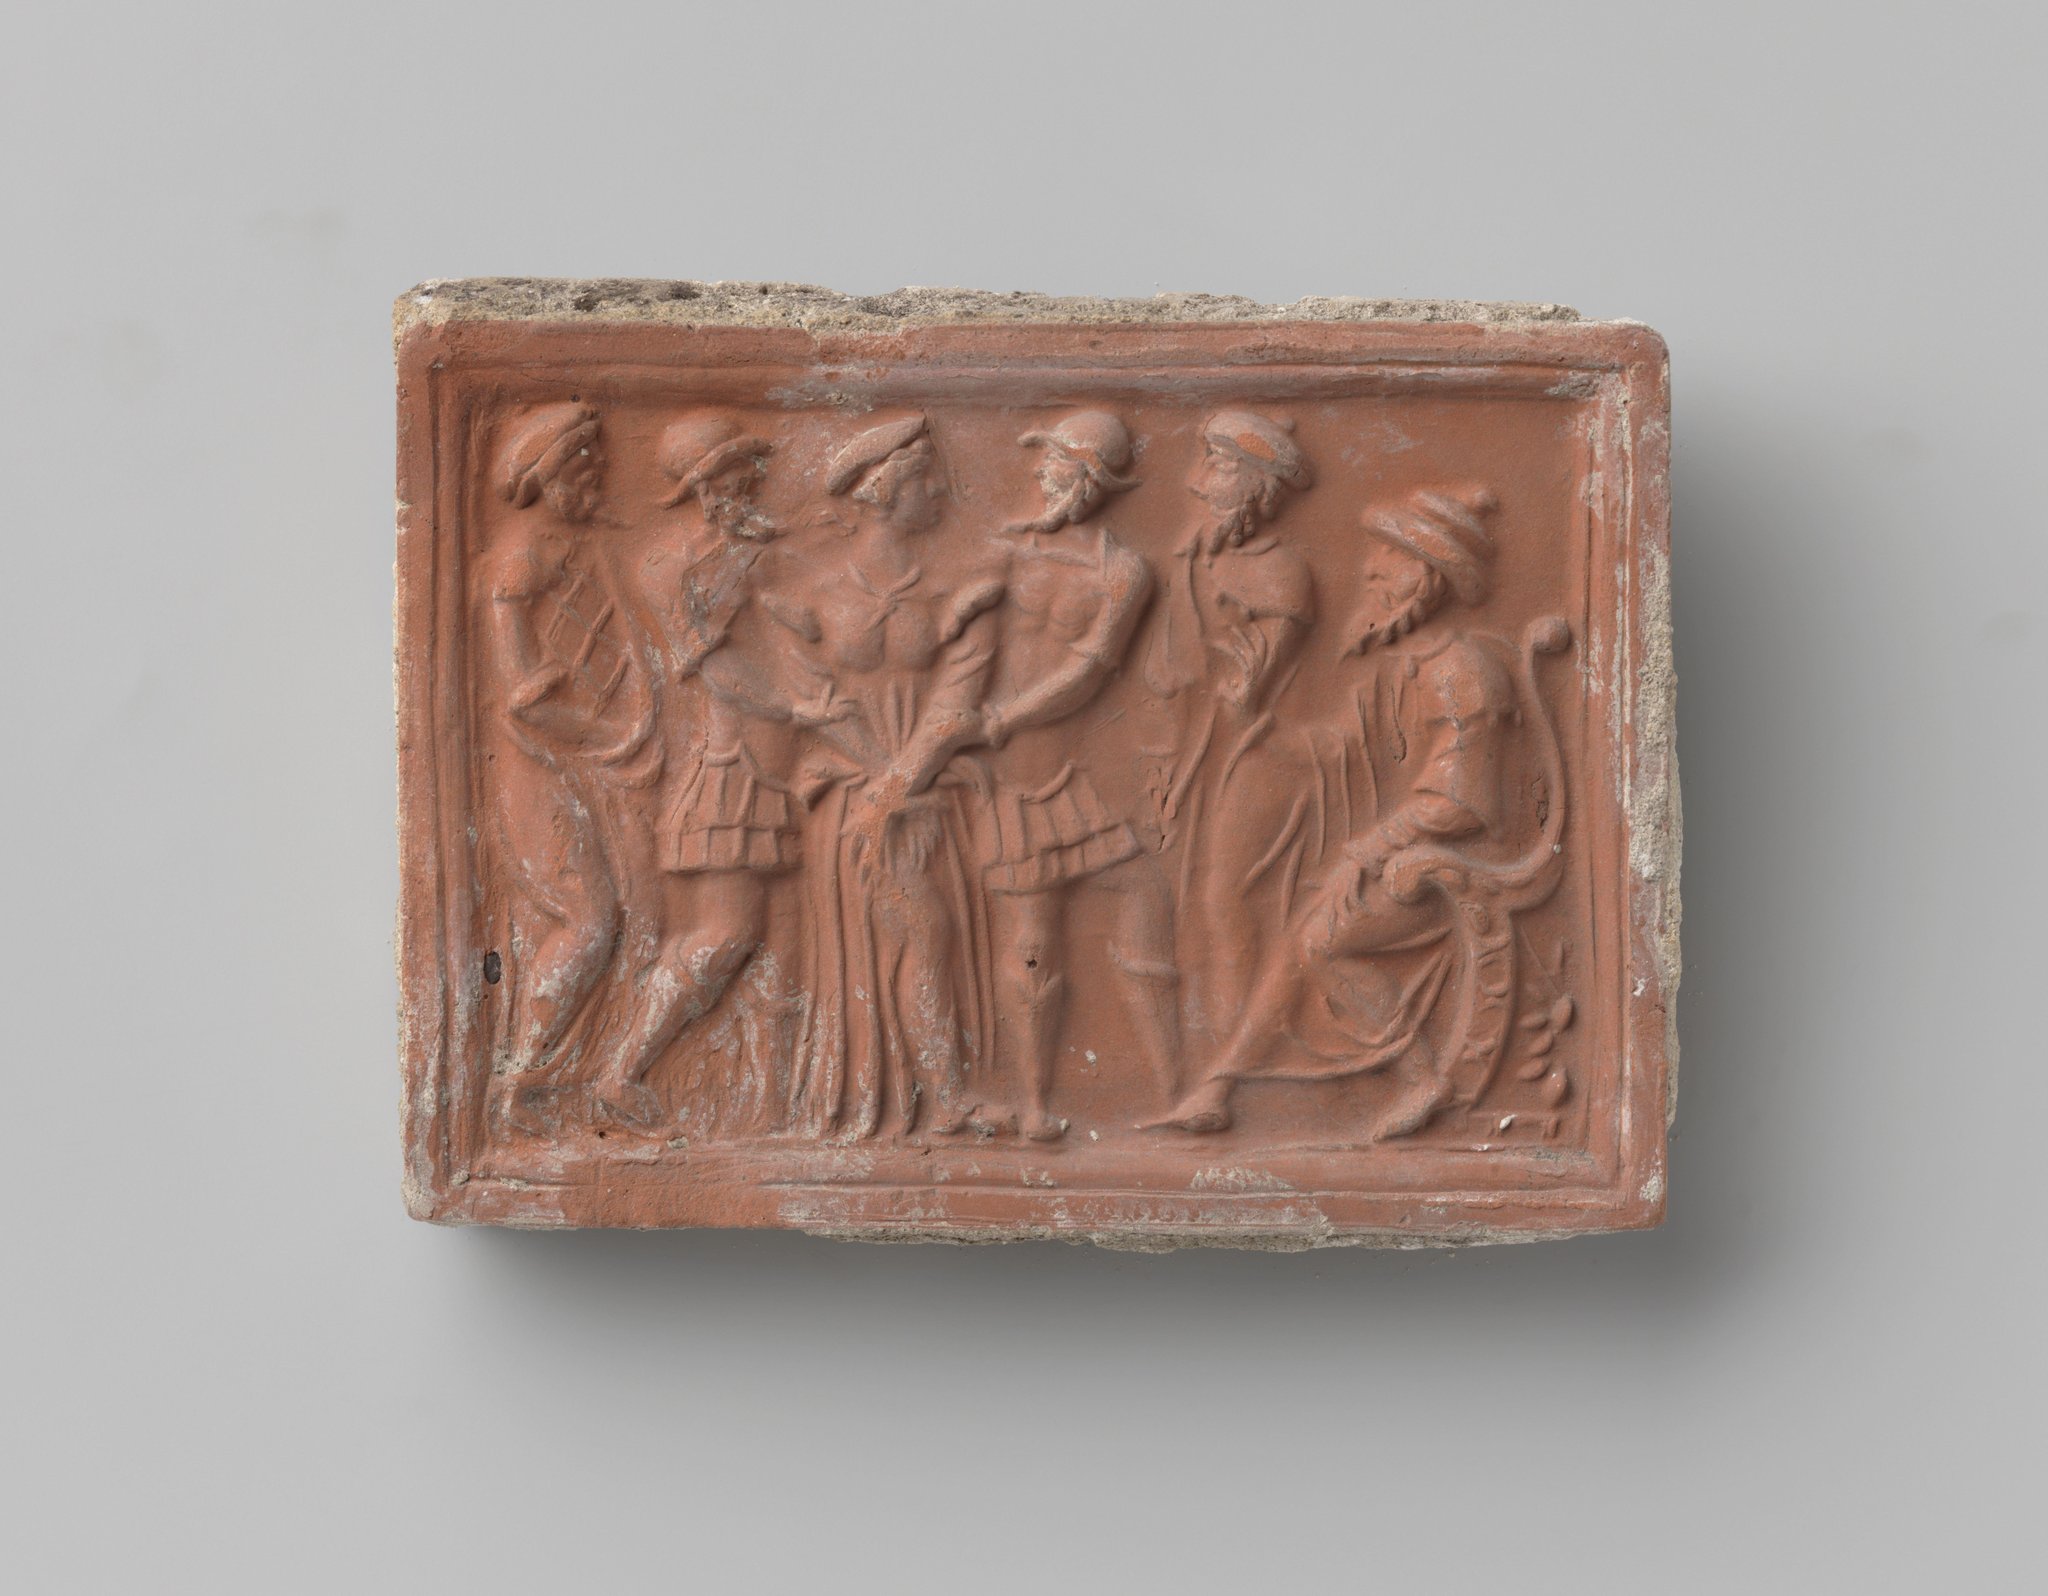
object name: hearthstone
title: Haardsteen met voorstelling van Suzanna, die door de twee ouderlingen voor de rechter wordt gevoerd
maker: Anonymous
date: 1875-1900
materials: earthenware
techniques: printing, firing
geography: netherlands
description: Haardsteen met voorstelling van Suzanna, die door de twee ouderlingen voor de rechter wordt gevoerd.